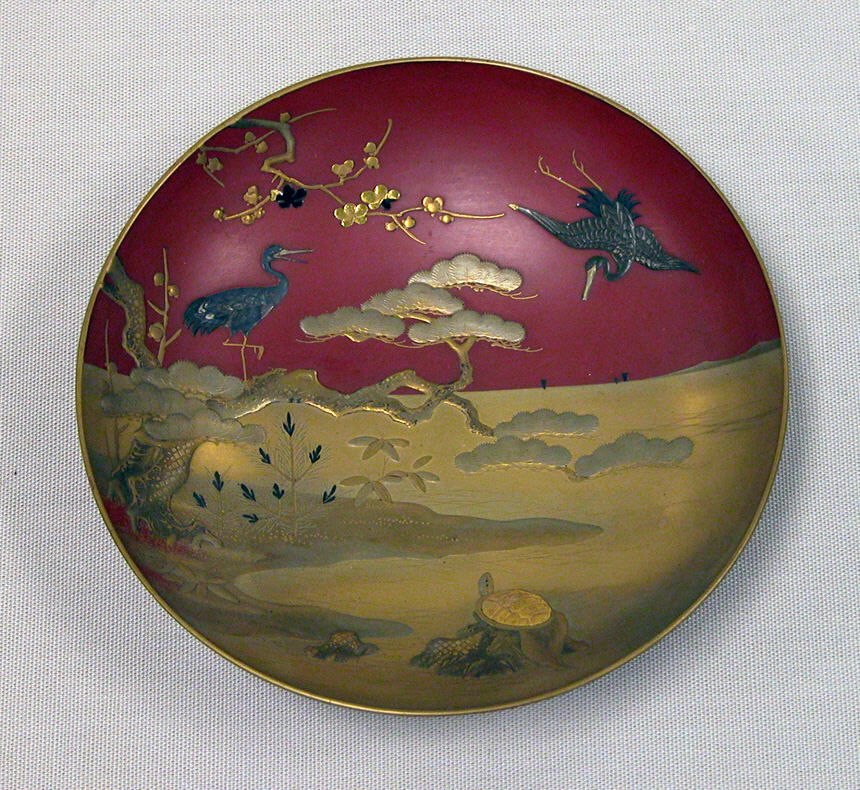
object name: wine cup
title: One of a Pair of Wine Cups (Sakazuki) with Mount Hōrai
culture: japanese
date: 1801-1900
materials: foil, gold, lacquer, silver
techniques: hiramakie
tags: cranes,leaves,trees